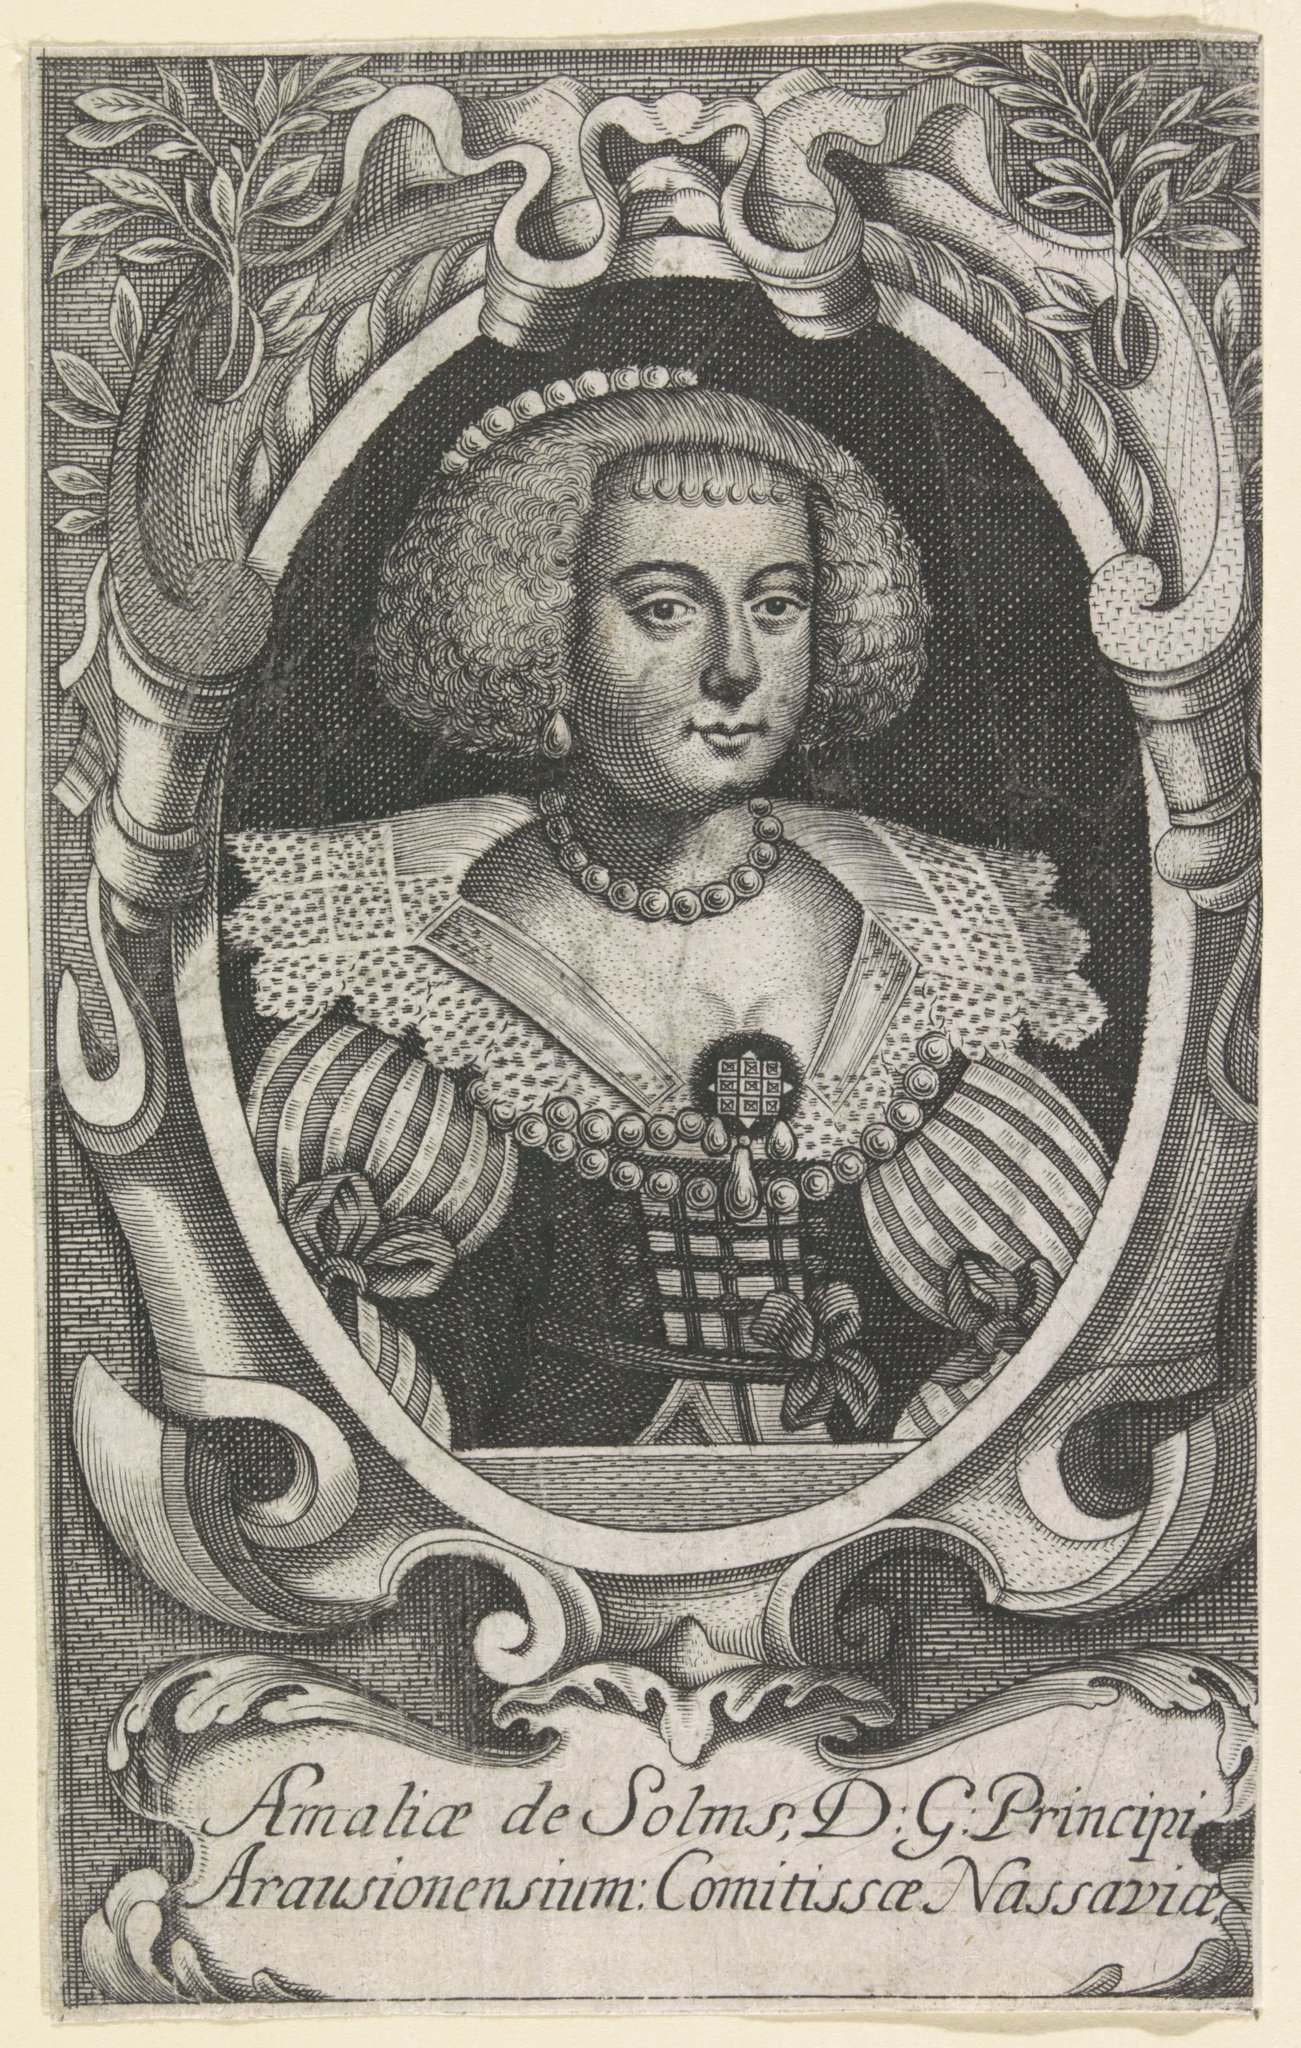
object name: print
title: Portret van Amalia van Solms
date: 1620-1668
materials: paper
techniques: engraving, etching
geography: low countries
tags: the hague, amalia of solms-braunfels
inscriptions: collector's mark: Lugt 2228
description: Portret van Amalia in een geornamenteerd ovaal. In een cartouche haar naam.